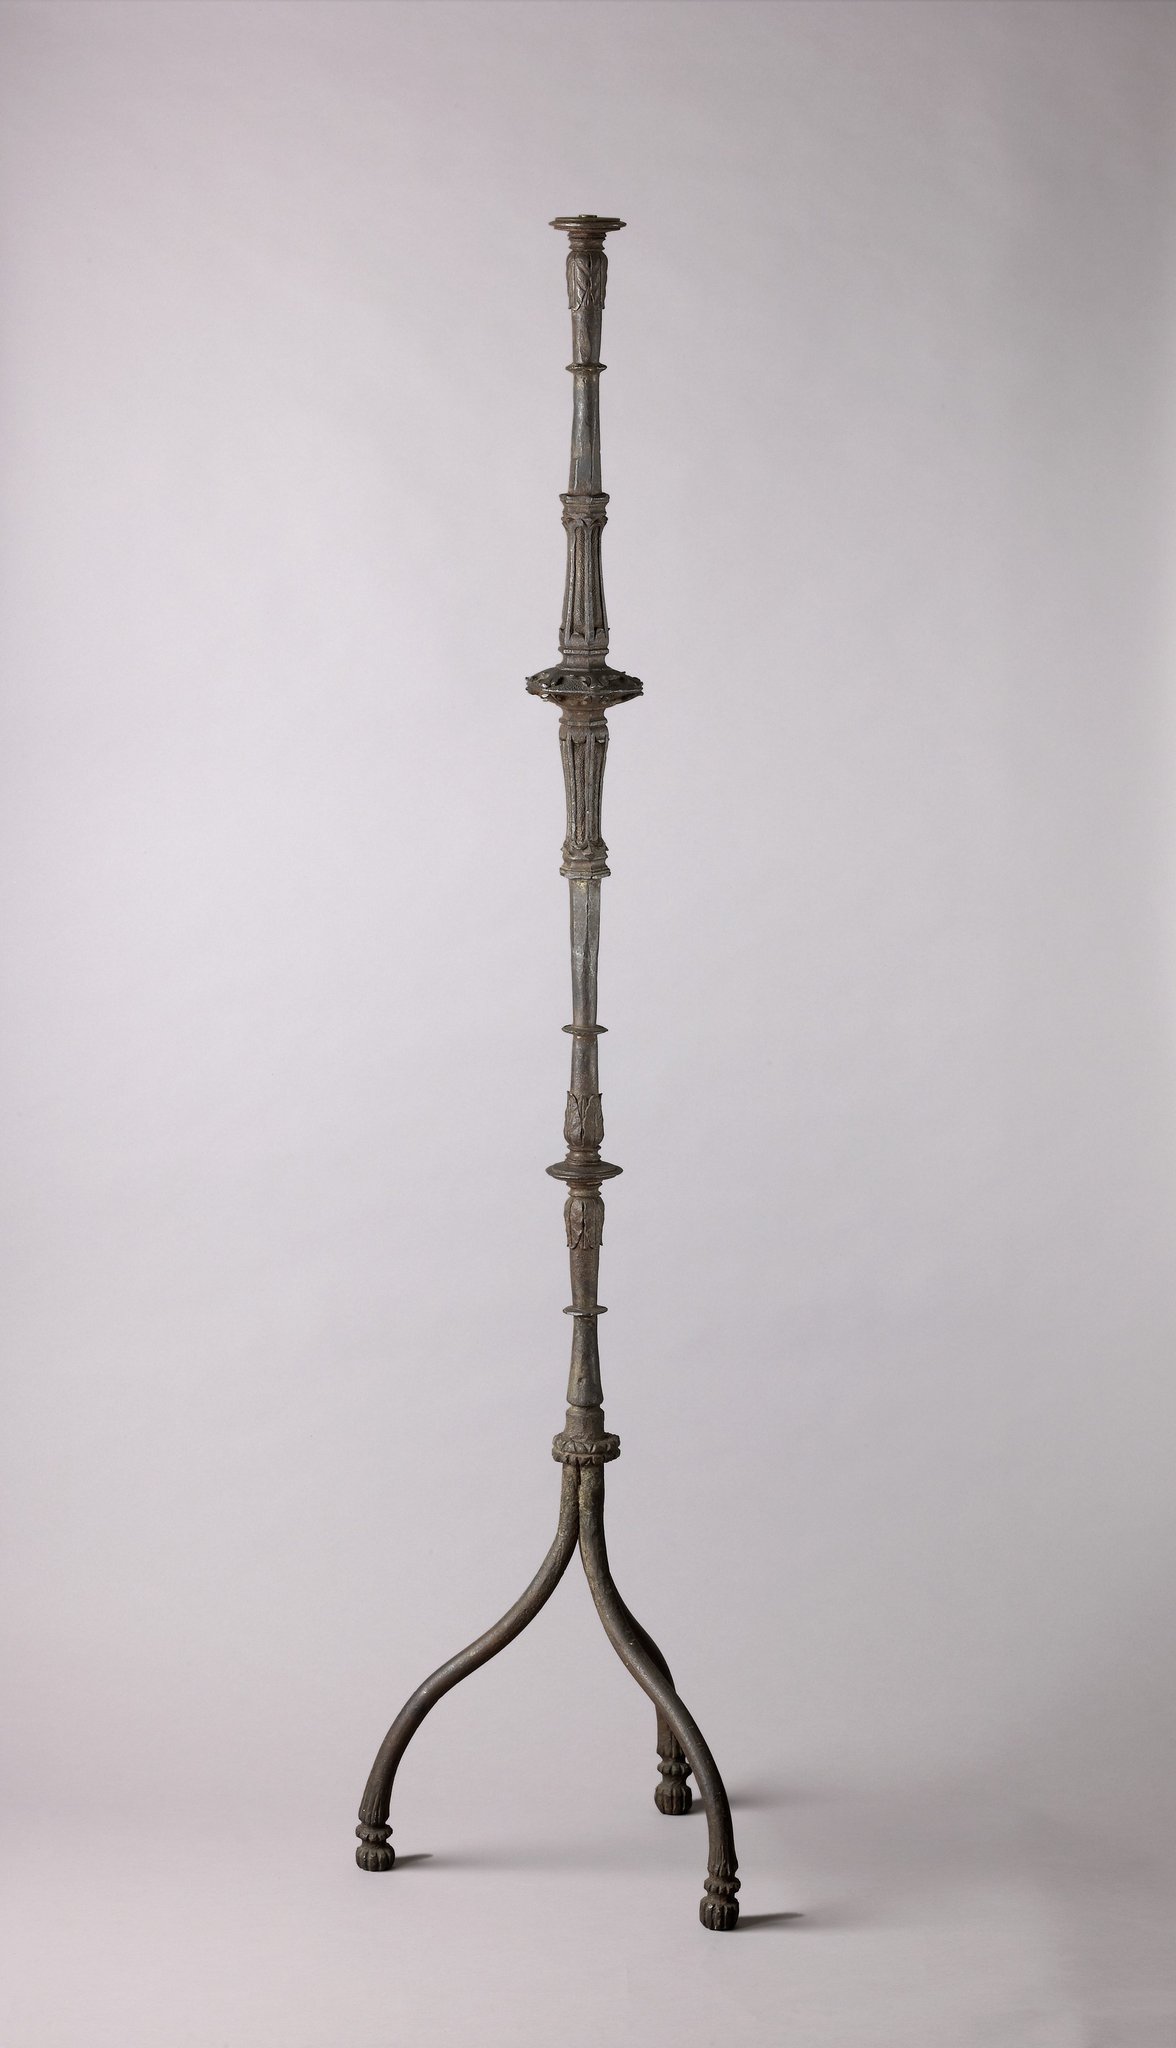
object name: candlestick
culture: french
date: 1701-1800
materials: iron